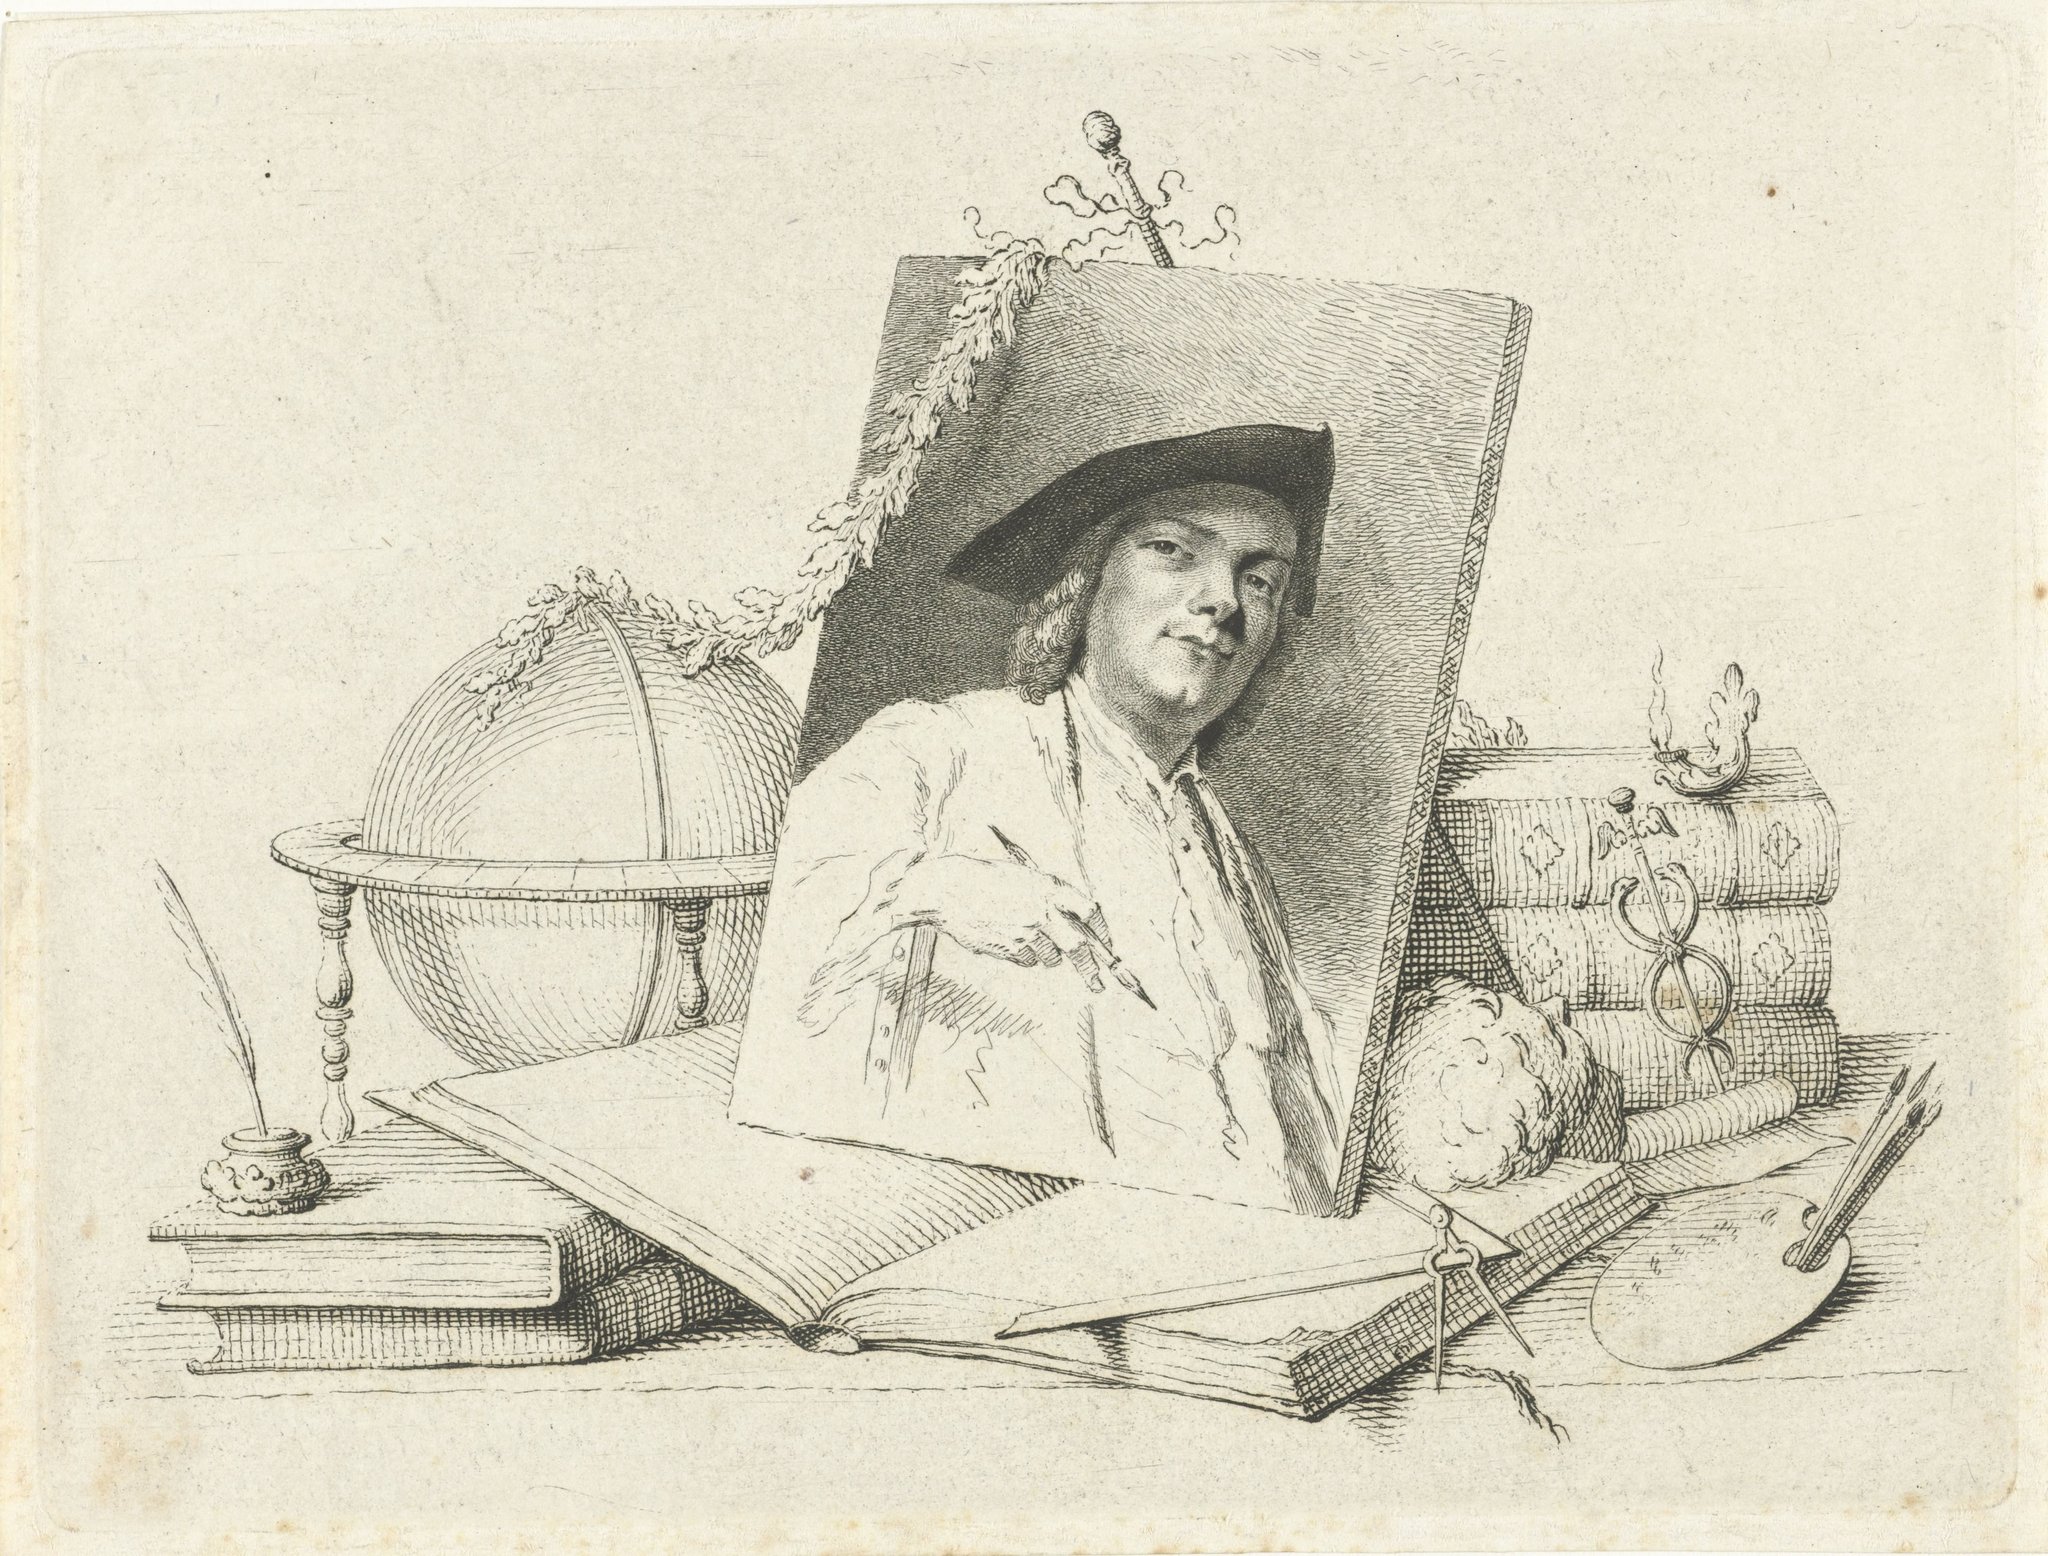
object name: print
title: Portret van Cornelis Ploos van Amstel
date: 1779-1798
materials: paper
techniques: etching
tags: cornelis ploos van amstel, writing tools, historical persons, book, caduceus (staff with two snakes, attribute of mercury), globe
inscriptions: collector's mark: Lugt 240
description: Het portret van Cornelis Ploos van Amstel op een schildersdoek. Naast het portret een globe, boeken, schrijfgerei, schilder- en graveergereedschap, een gebeeldhouwde kop en de mercuriusstaf.